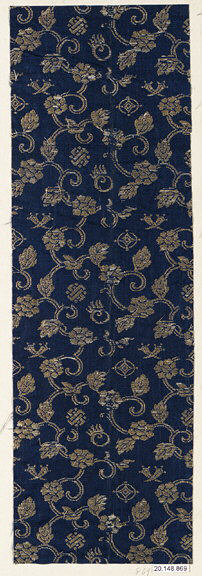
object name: piece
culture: japanese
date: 1701-1800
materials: silk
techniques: compound weave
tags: flowers